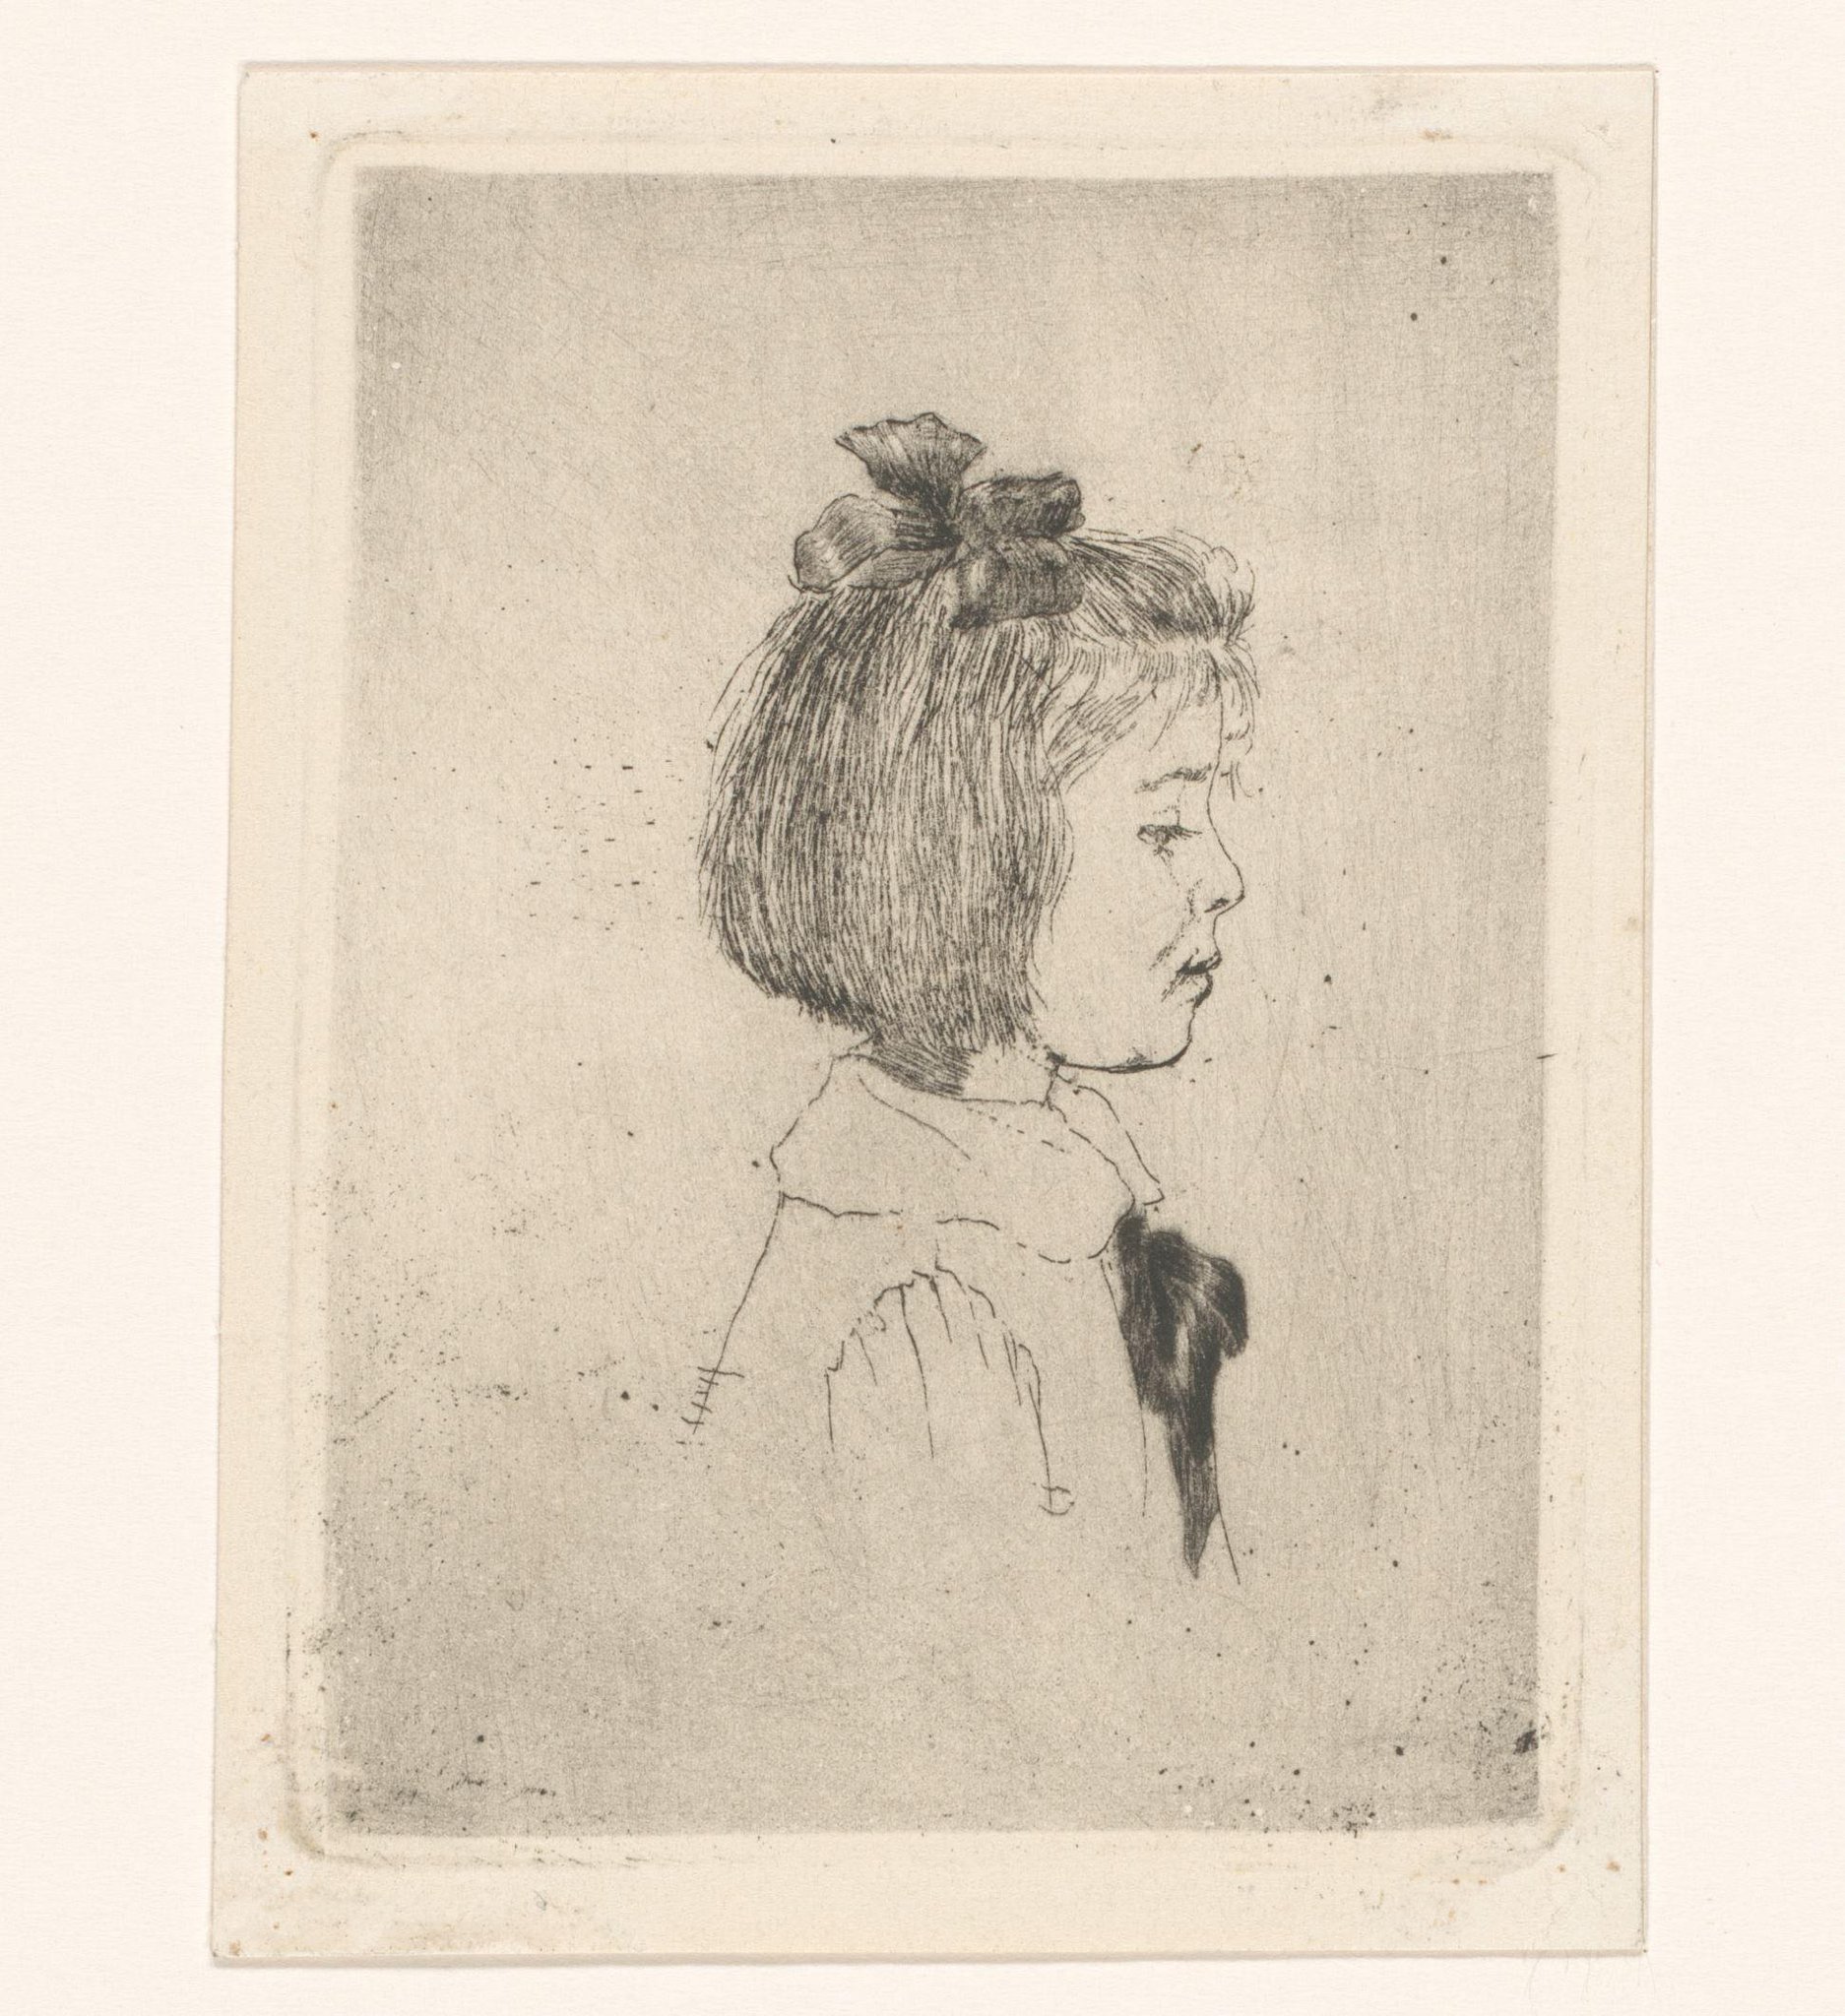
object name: print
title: Portret van een onbekend meisje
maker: dora struick du moulin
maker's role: draughtsman, print maker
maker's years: 1866-1937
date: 1896-1937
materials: paper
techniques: etching, intaglio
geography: netherlands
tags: historical persons not known by name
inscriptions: inscription: ‘aanw 1923’, collector's mark: Lugt 2760, collector's mark: Lugt 2228